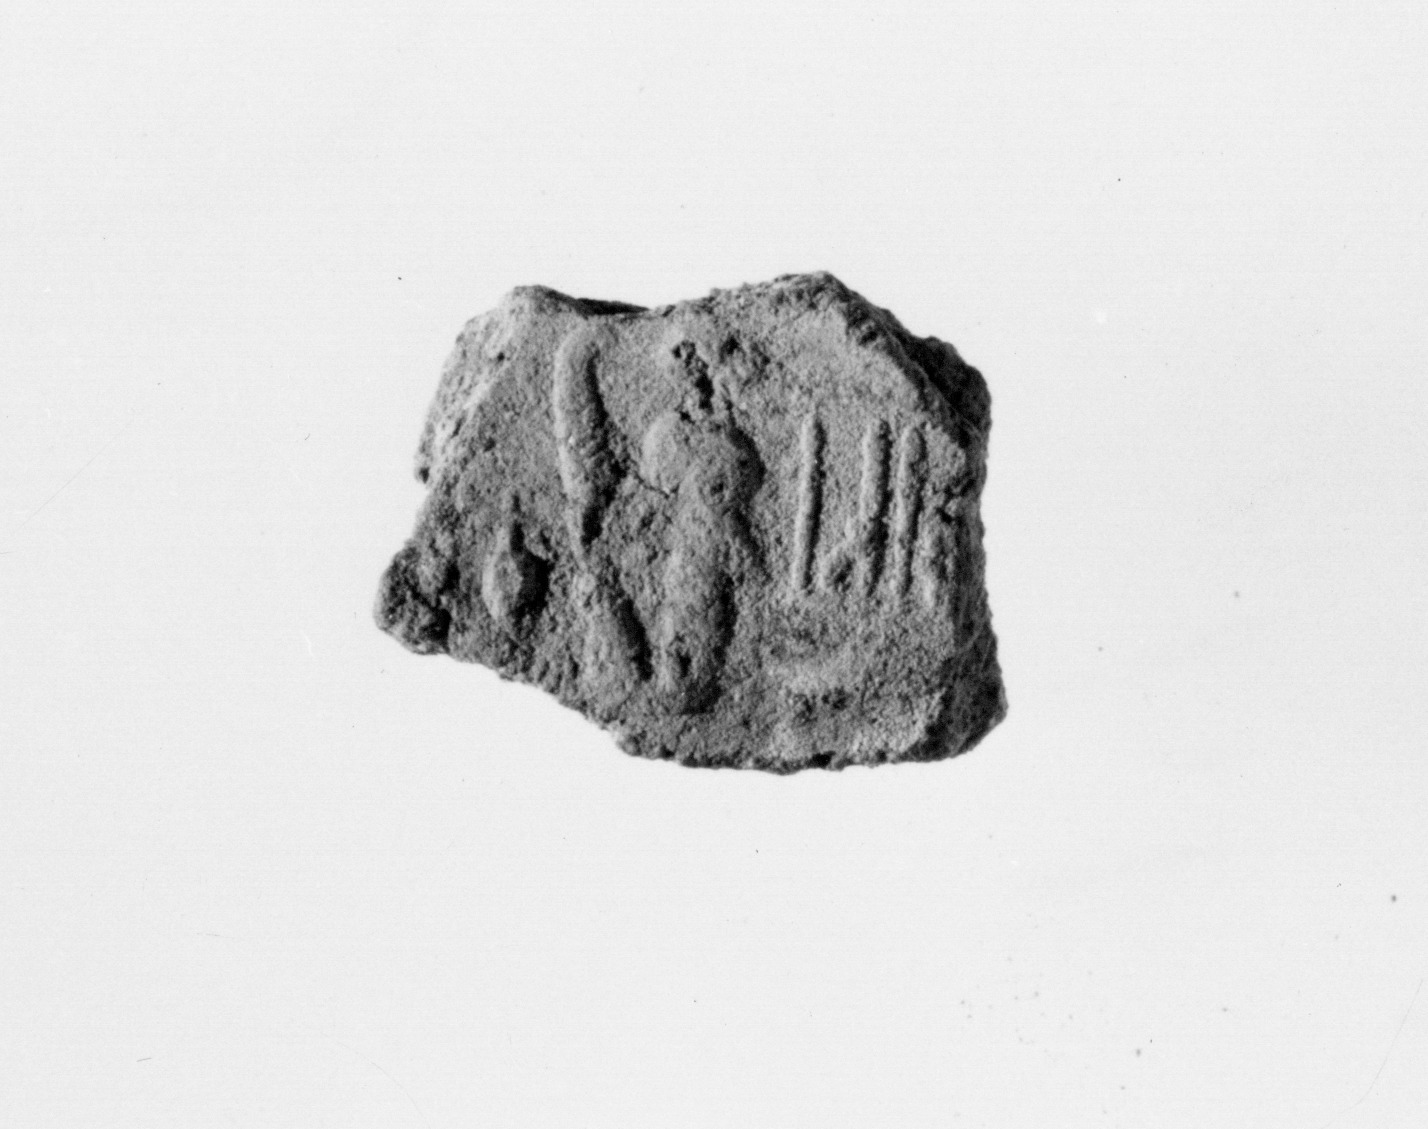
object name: sealing, nebmaatre, amenhotep iii, heb sed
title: Document Sealing With the Throne Name of Amenhotep III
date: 1390-1352 BCE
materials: mud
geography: egypt